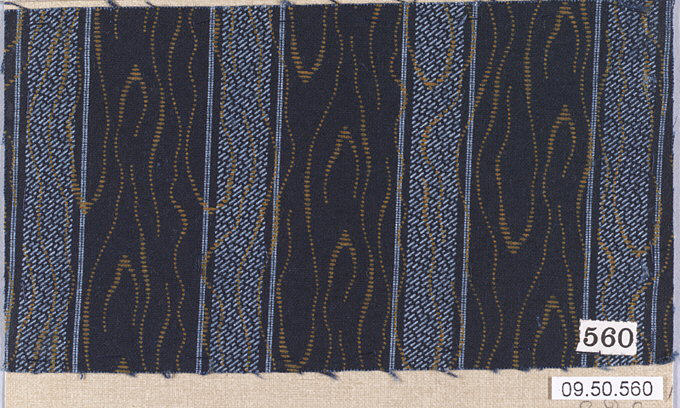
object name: piece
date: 1801-1900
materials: cotton